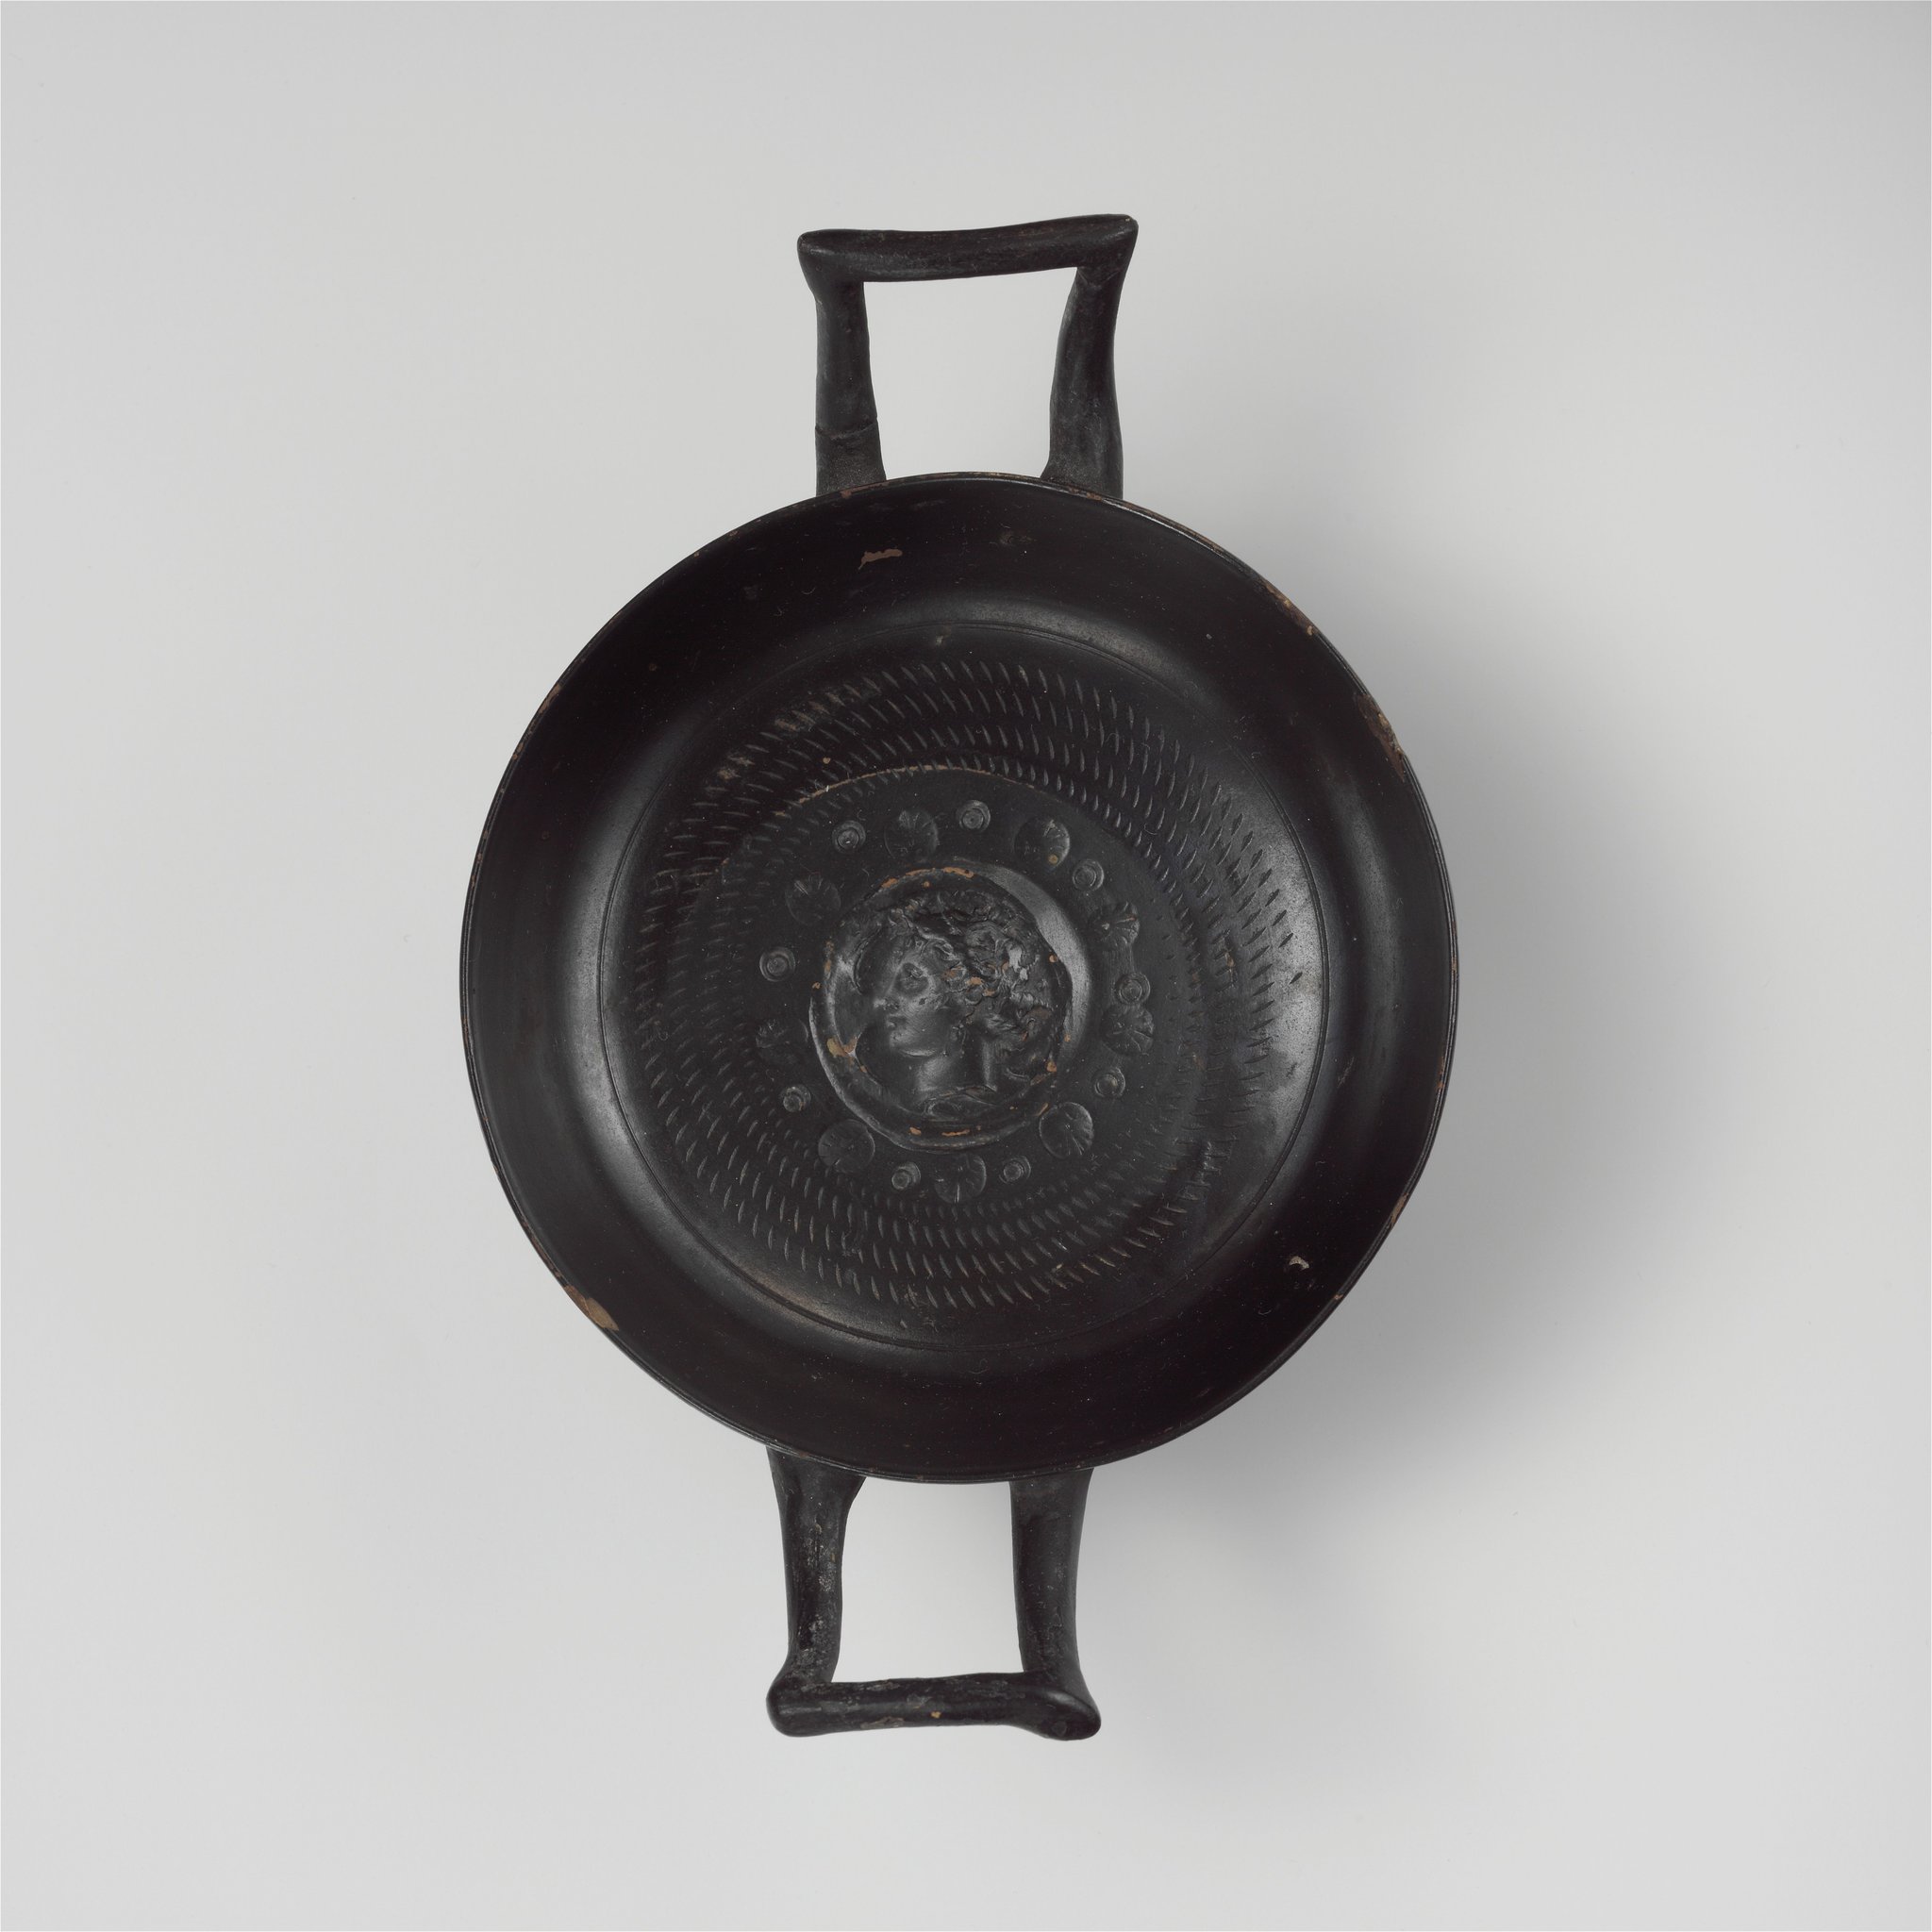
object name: kylix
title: Terracotta stemless kylix (drinking cup)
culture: greek, calenian or campanian or south italian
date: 334-201 BCE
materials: terracotta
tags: heads